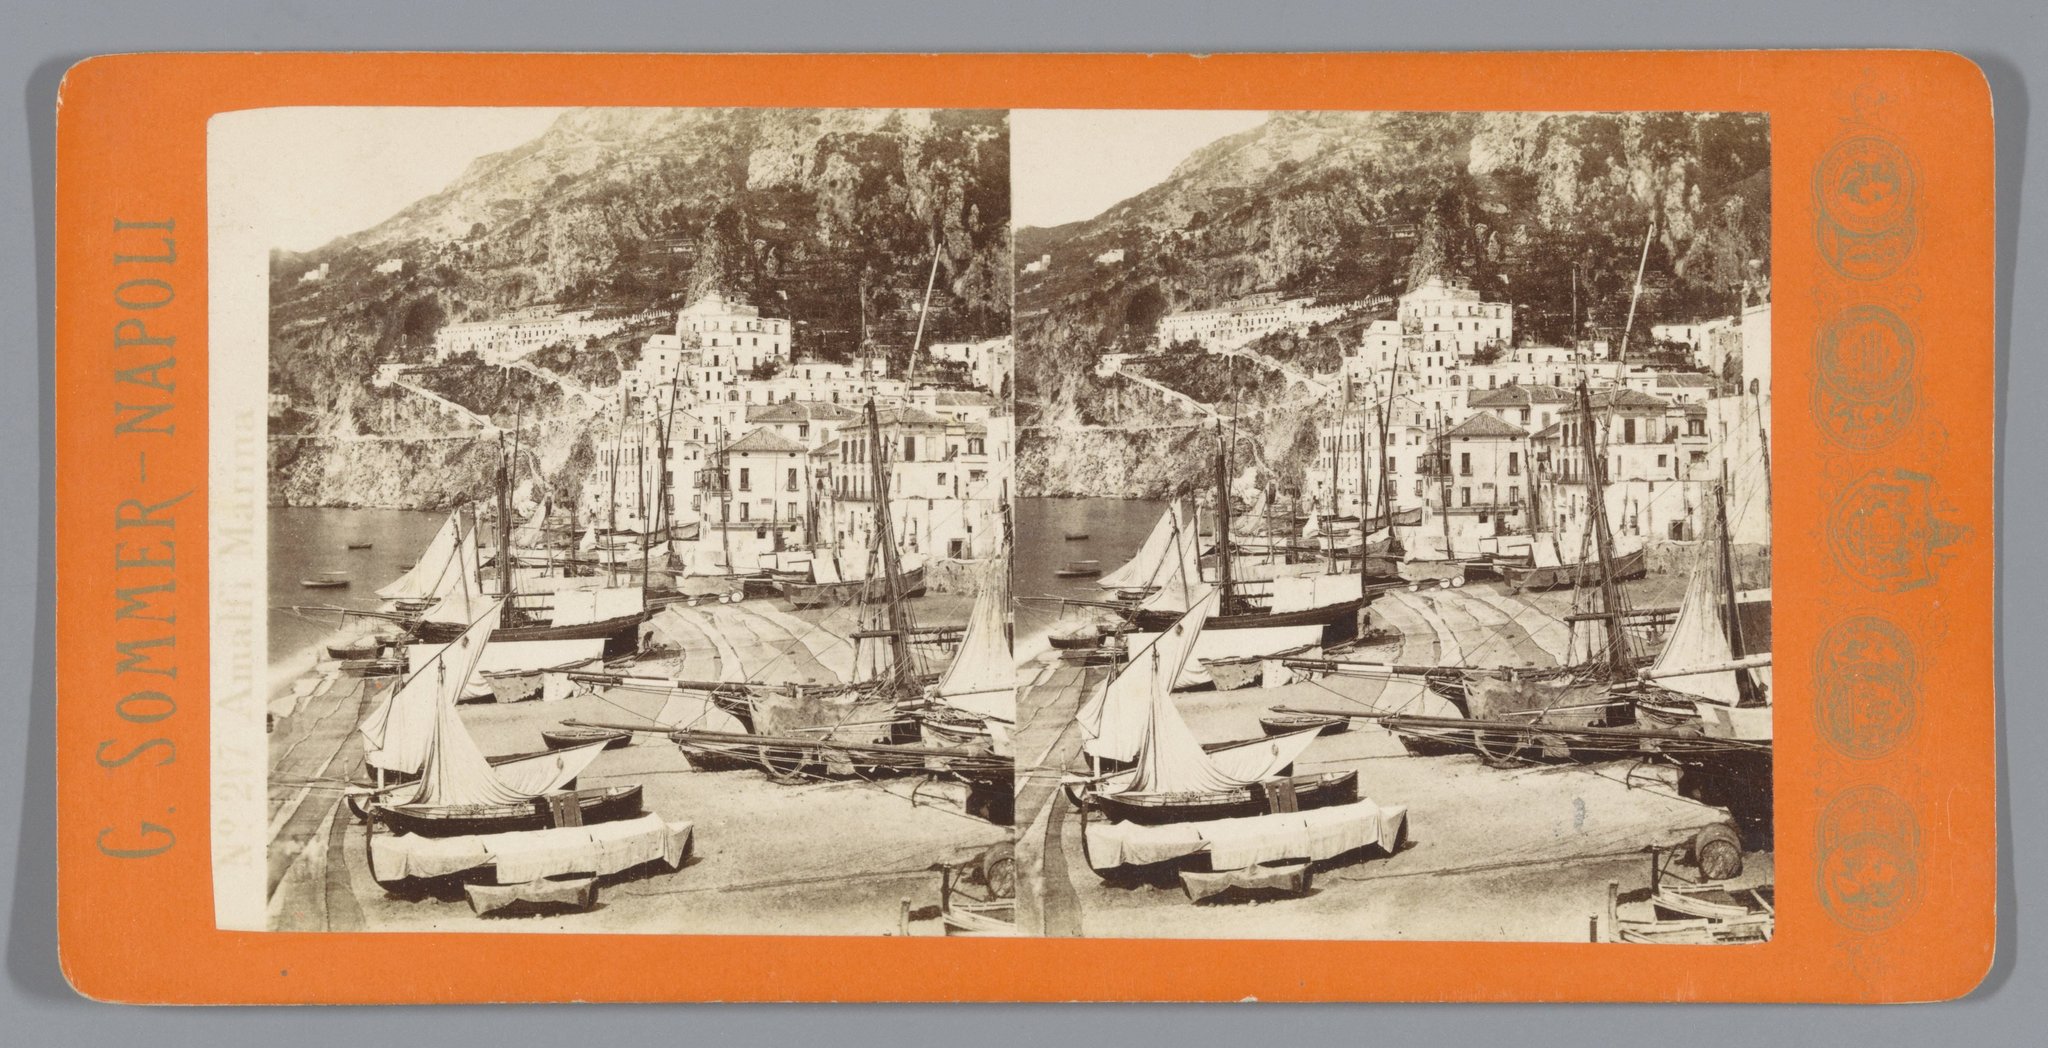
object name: stereograph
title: Gezicht op de haven van Amalfi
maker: giorgio sommer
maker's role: fotograaf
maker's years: 1834-1914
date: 1860-1880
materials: cardboard, photographic support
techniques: albumen print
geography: amalfi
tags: harbour, amalfi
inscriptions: inscription: ‘Amalfi Marina’, number: ‘No. 217’